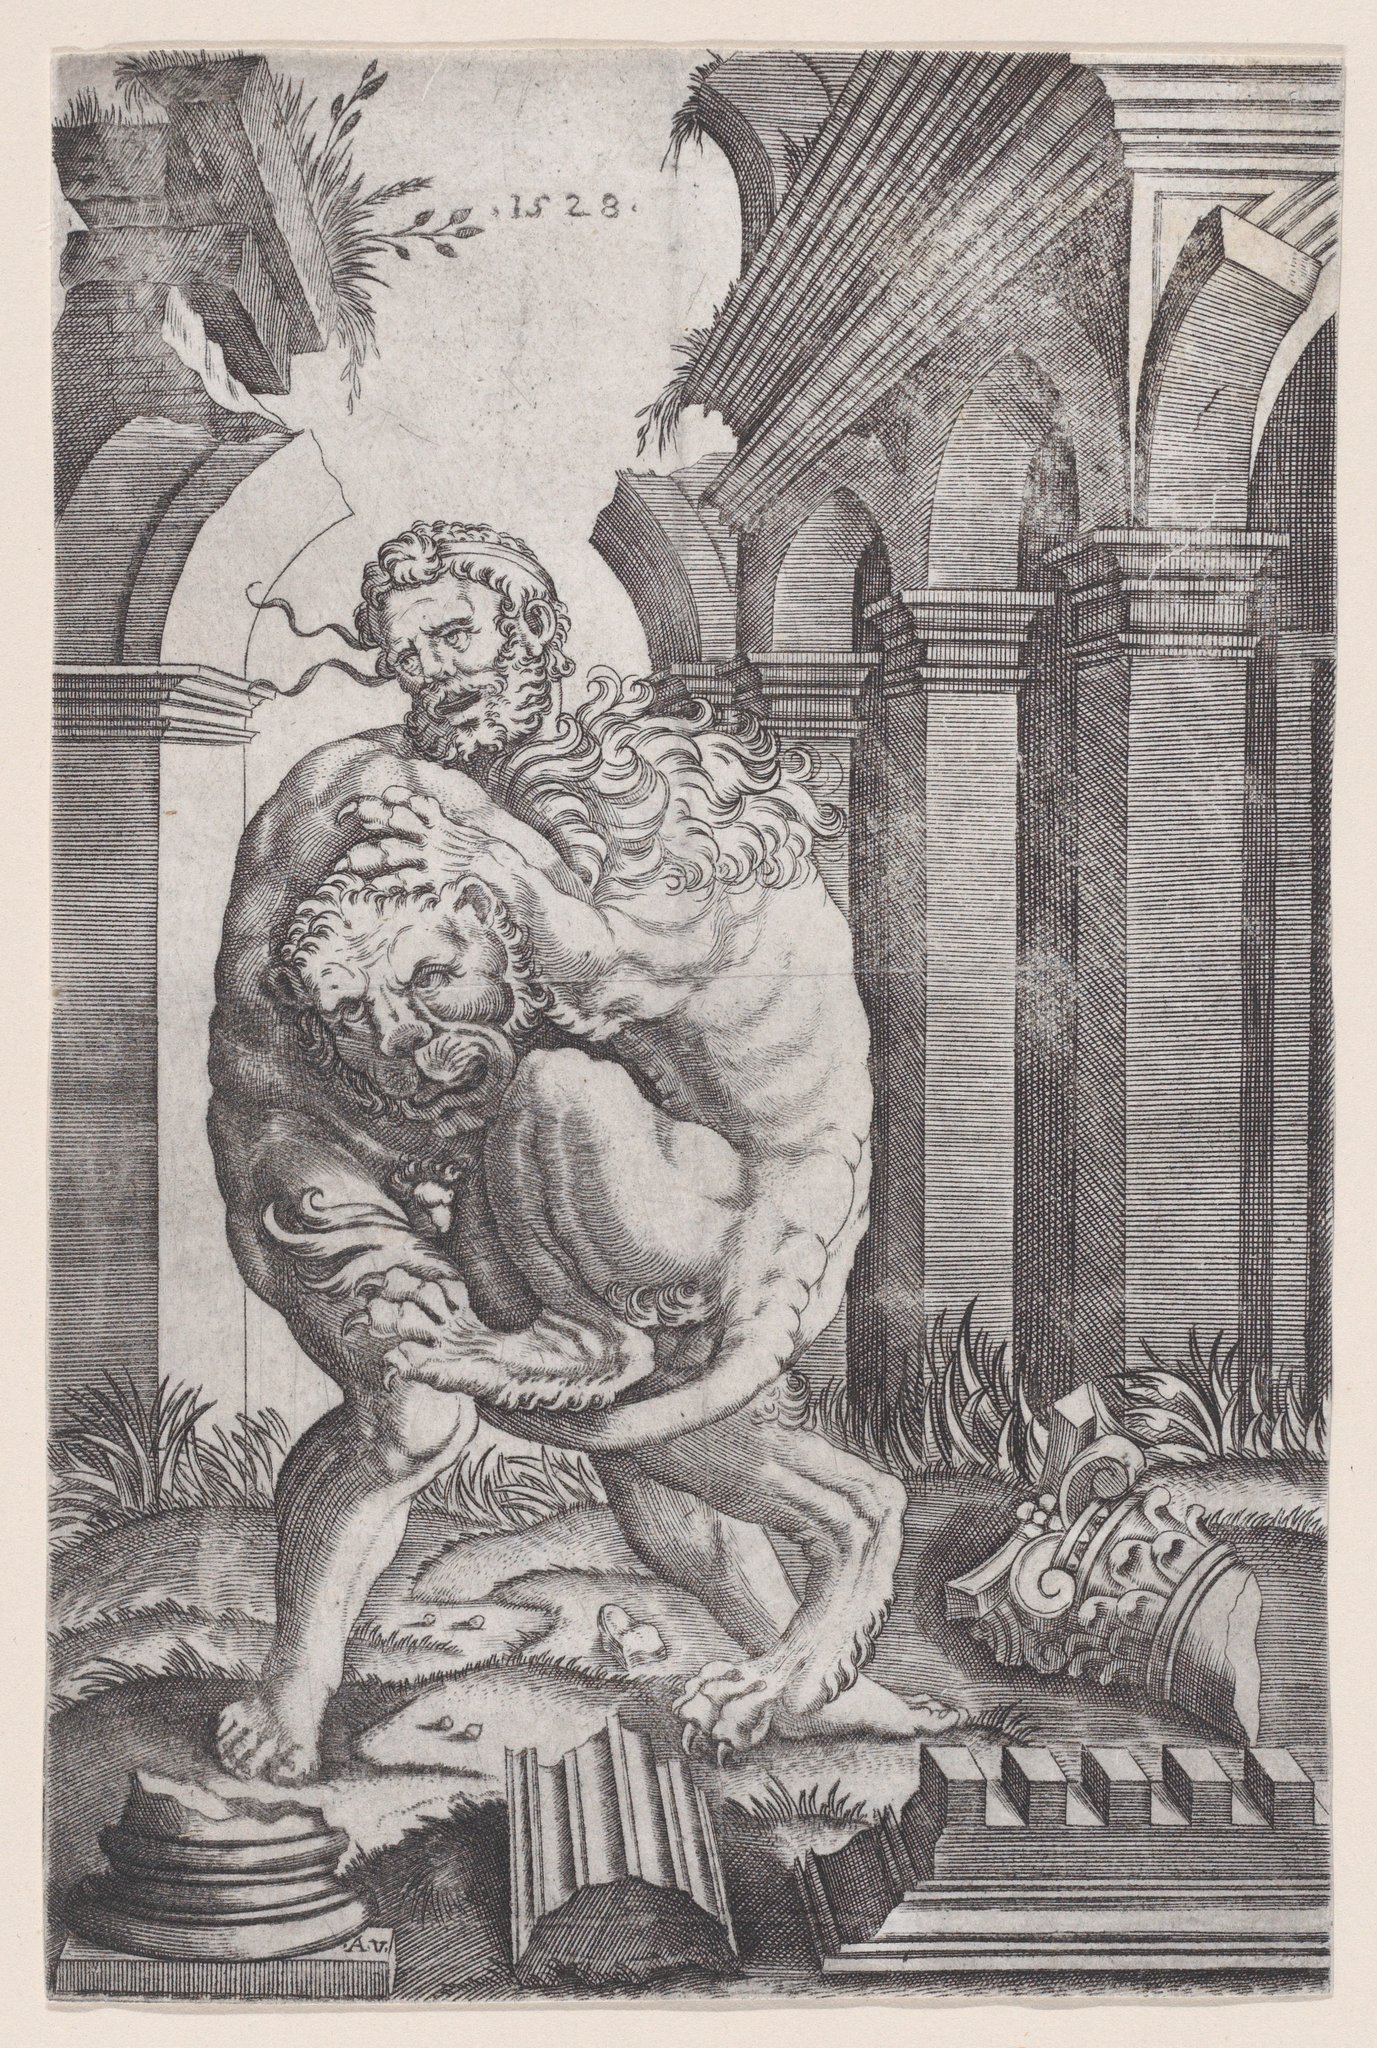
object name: print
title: Hercules Strangling the Nemean Lion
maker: agostino veneziano (agostino dei musi)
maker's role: artist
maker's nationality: italian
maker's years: 1490-1536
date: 1528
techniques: engraving